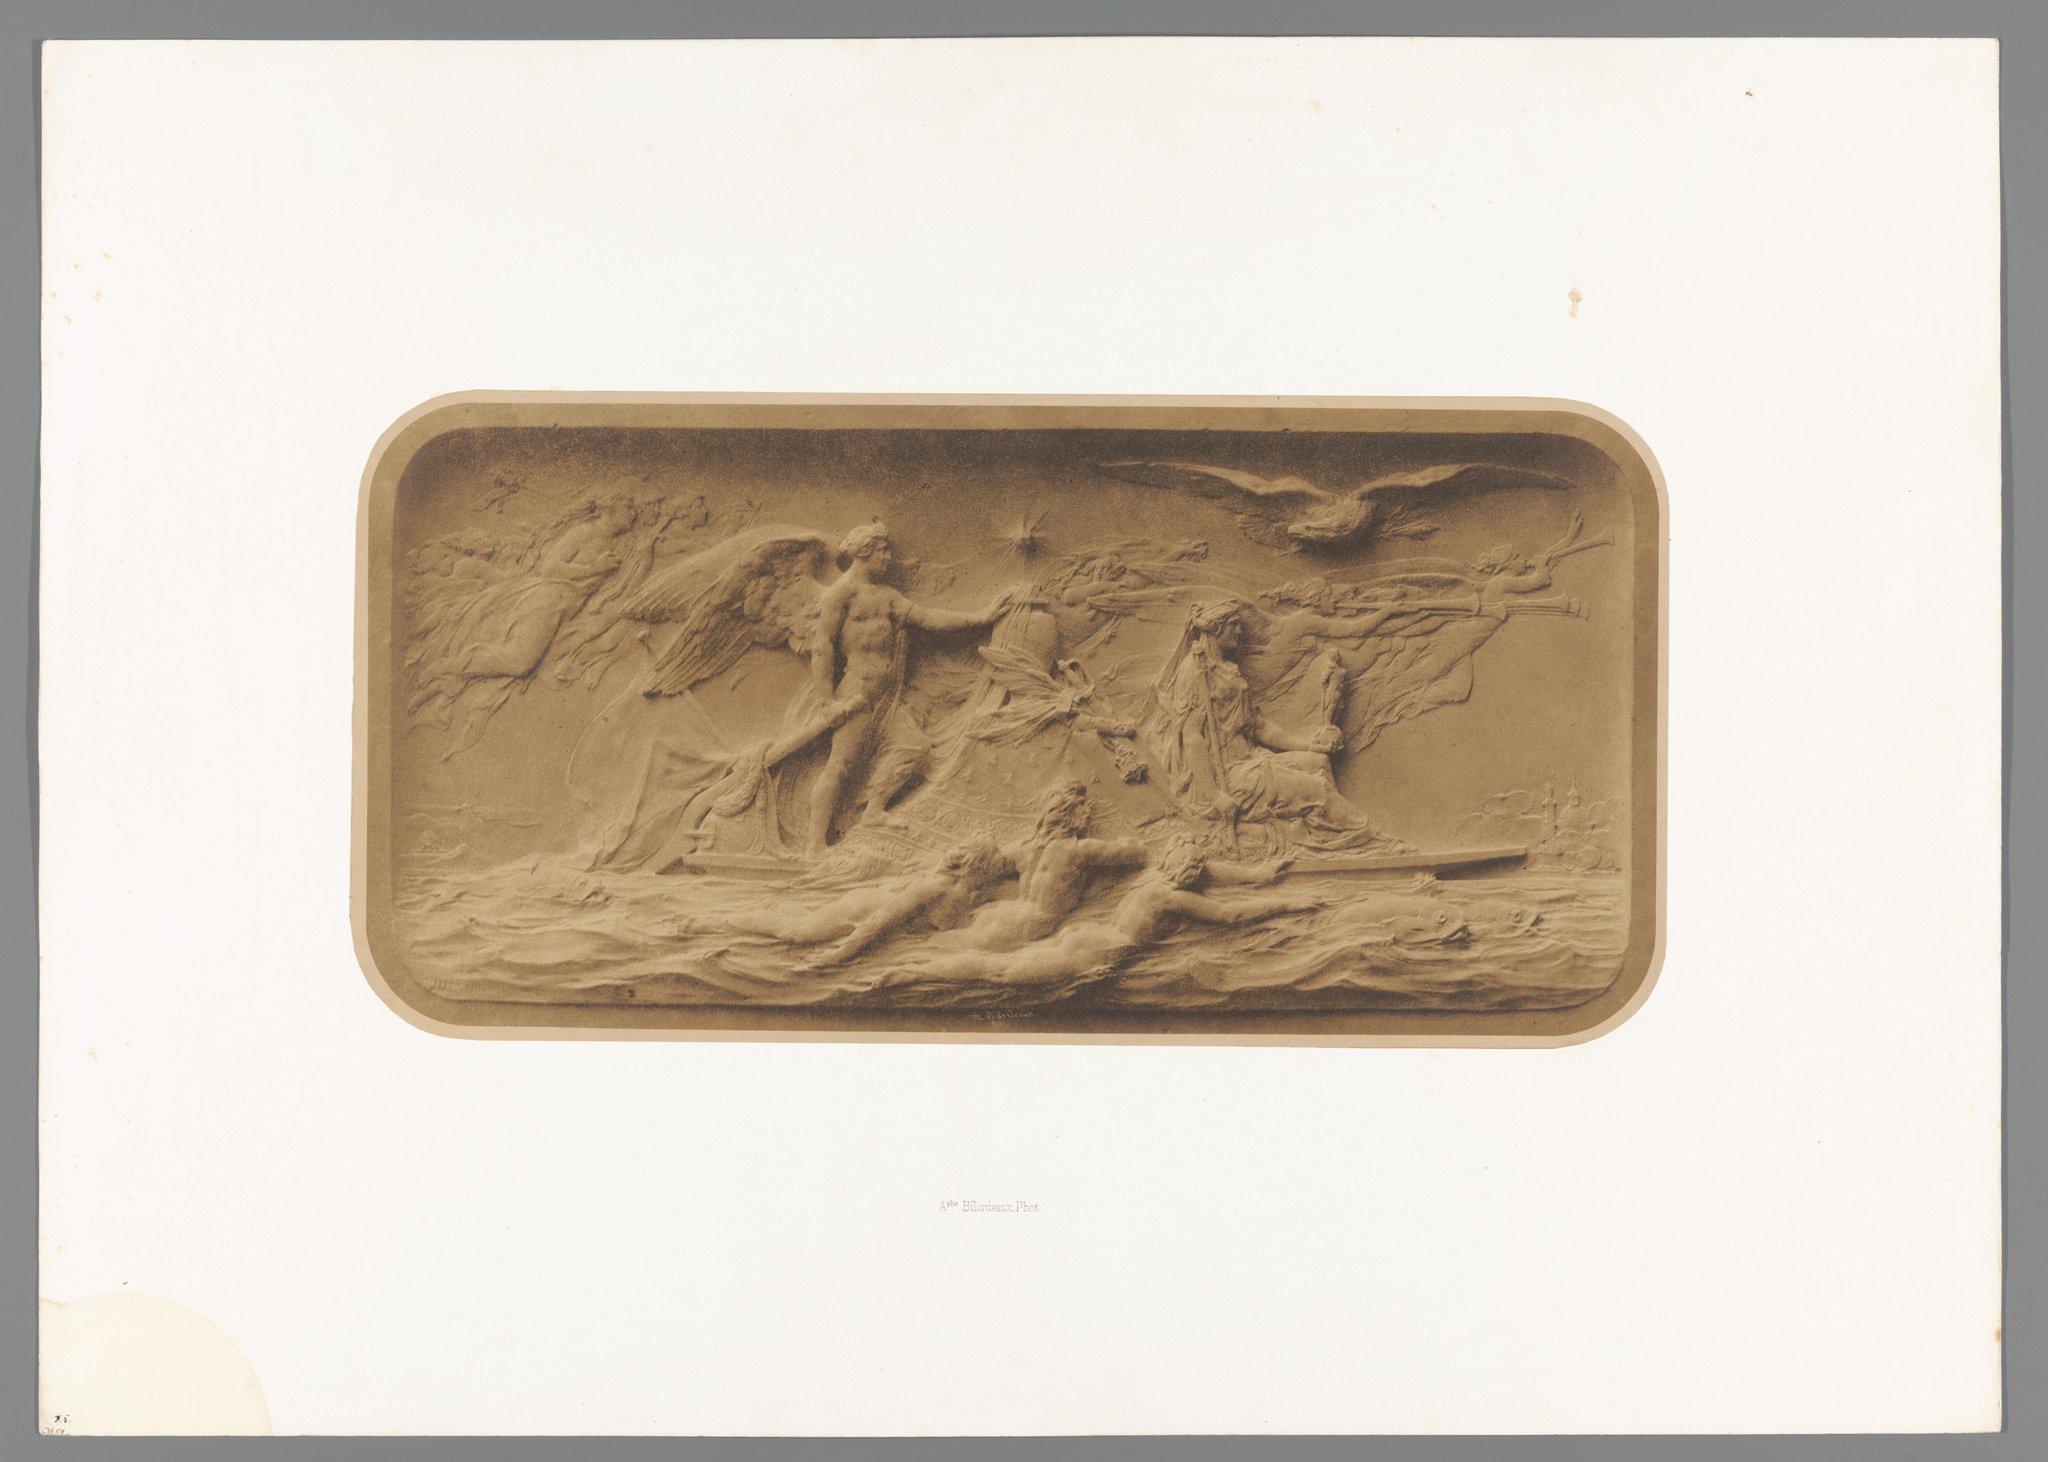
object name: photograph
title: Reliëf aan de Arc de Triomphe te Parijs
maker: adolphe bilordeaux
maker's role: draughtsman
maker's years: 1807-1872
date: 1850-1860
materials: cardboard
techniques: salted paper print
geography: paris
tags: piece of sculpture, reproduction of a piece of sculpture